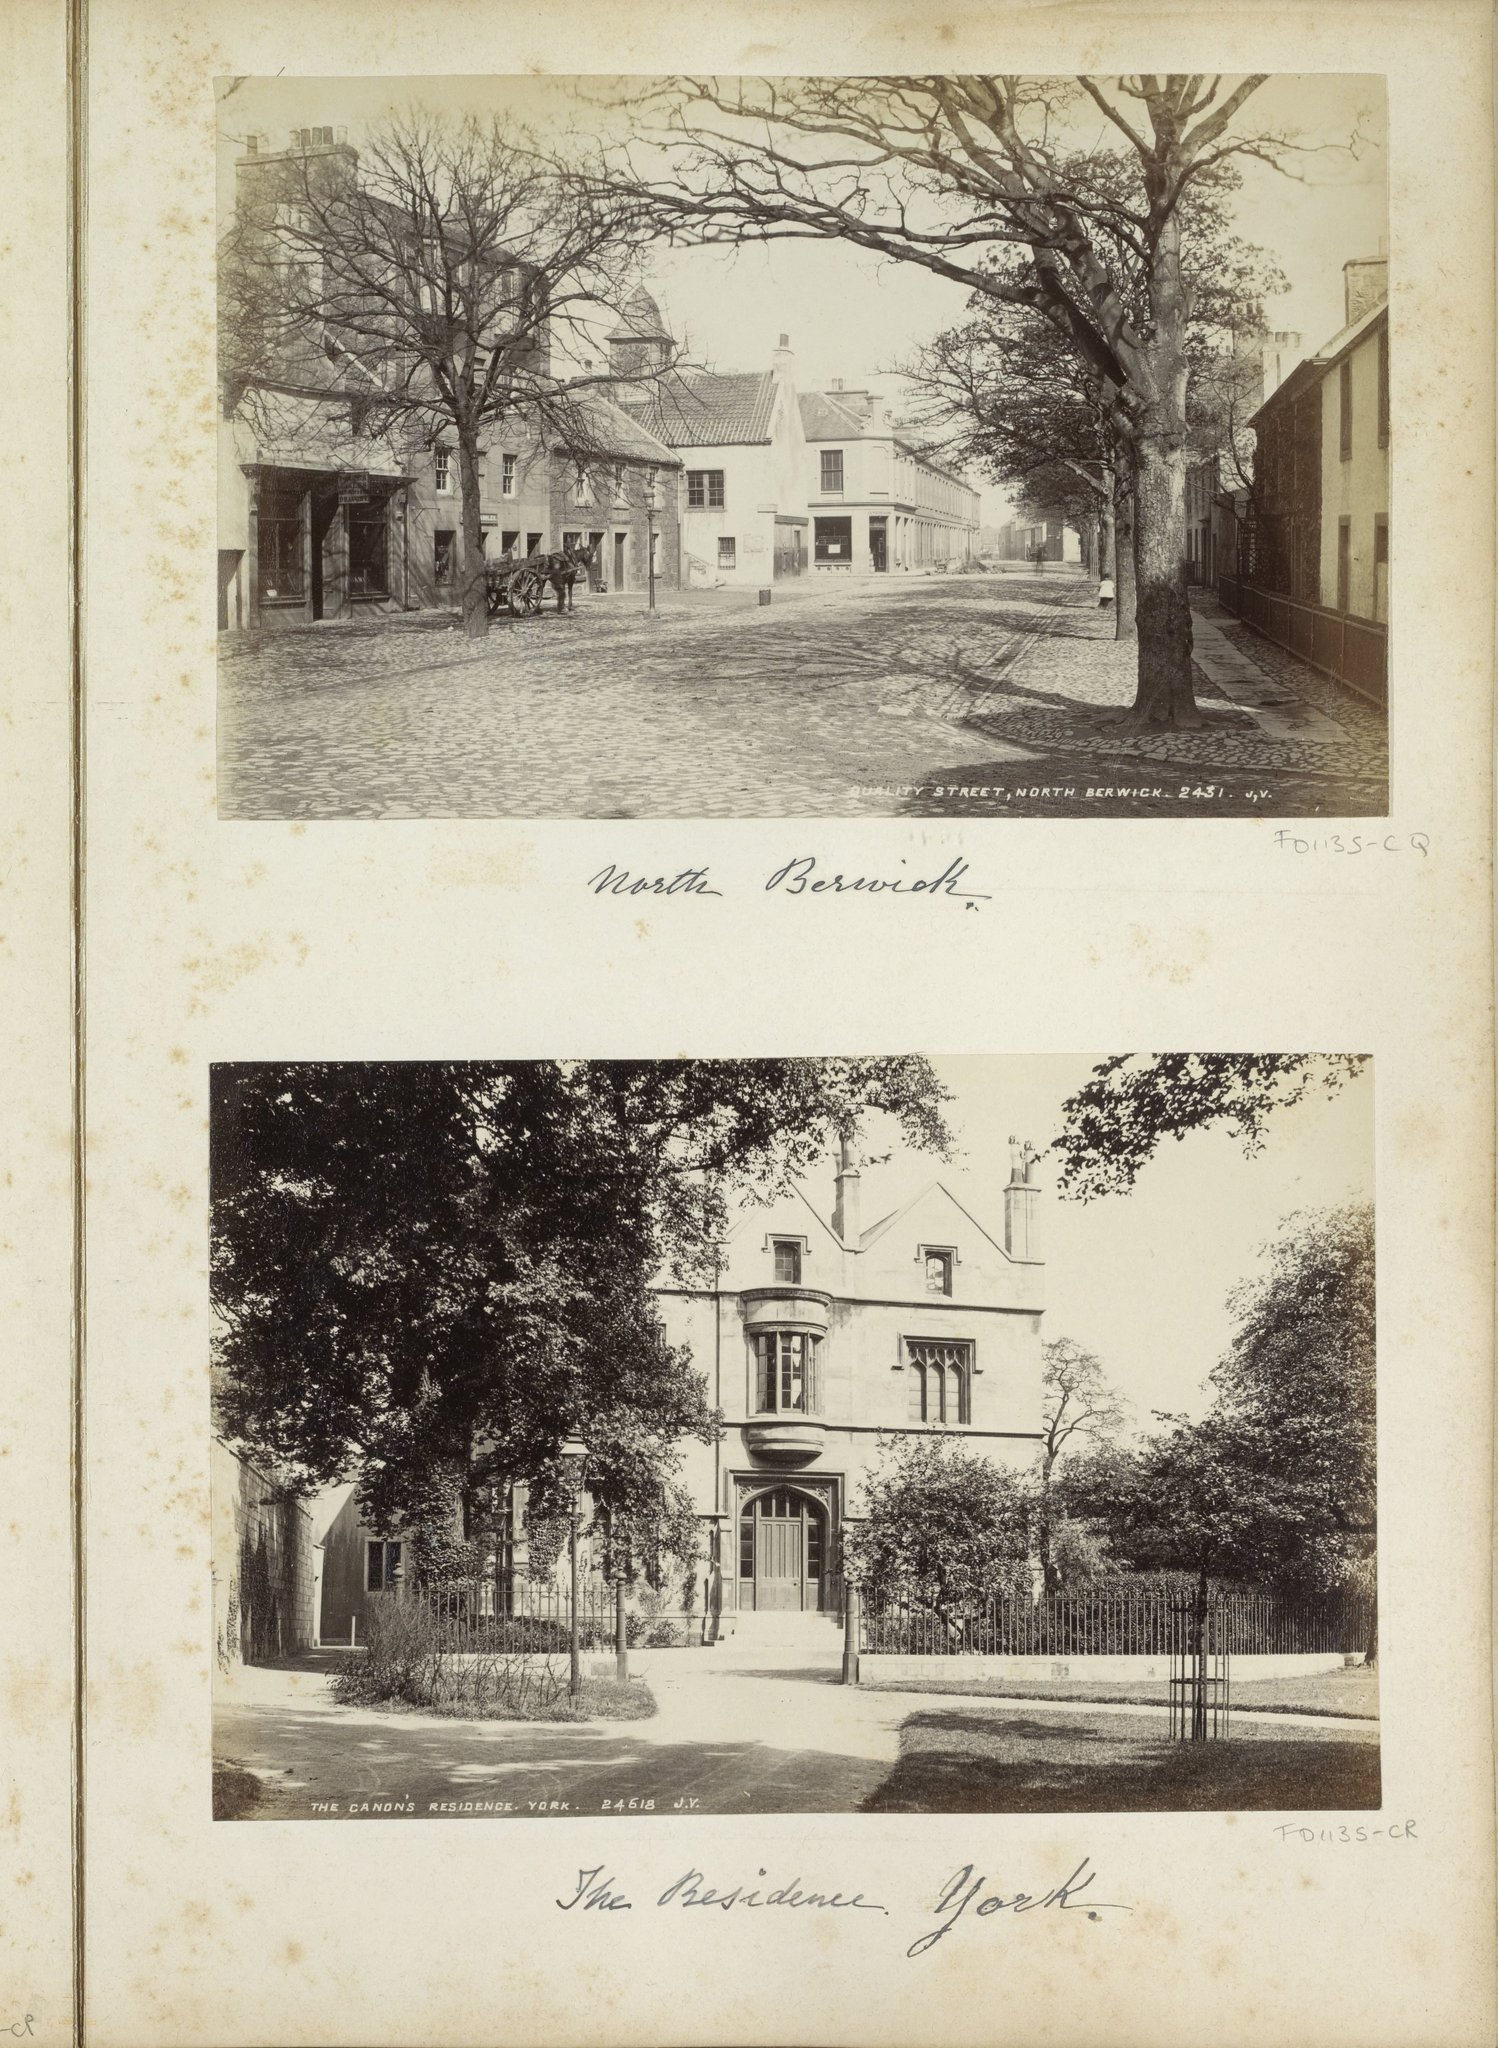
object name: photograph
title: Quality Street in North Berwick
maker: james valentine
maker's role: fotograaf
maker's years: 1815-1880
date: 1900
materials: paper, photographic support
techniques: albumen print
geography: north berwick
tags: two-wheeled, animal-drawn vehicle, village street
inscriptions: negative number: ‘2431’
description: Onderdeel van Reisalbum met foto's van bezienswaardigheden in Engeland en Frankrijk.